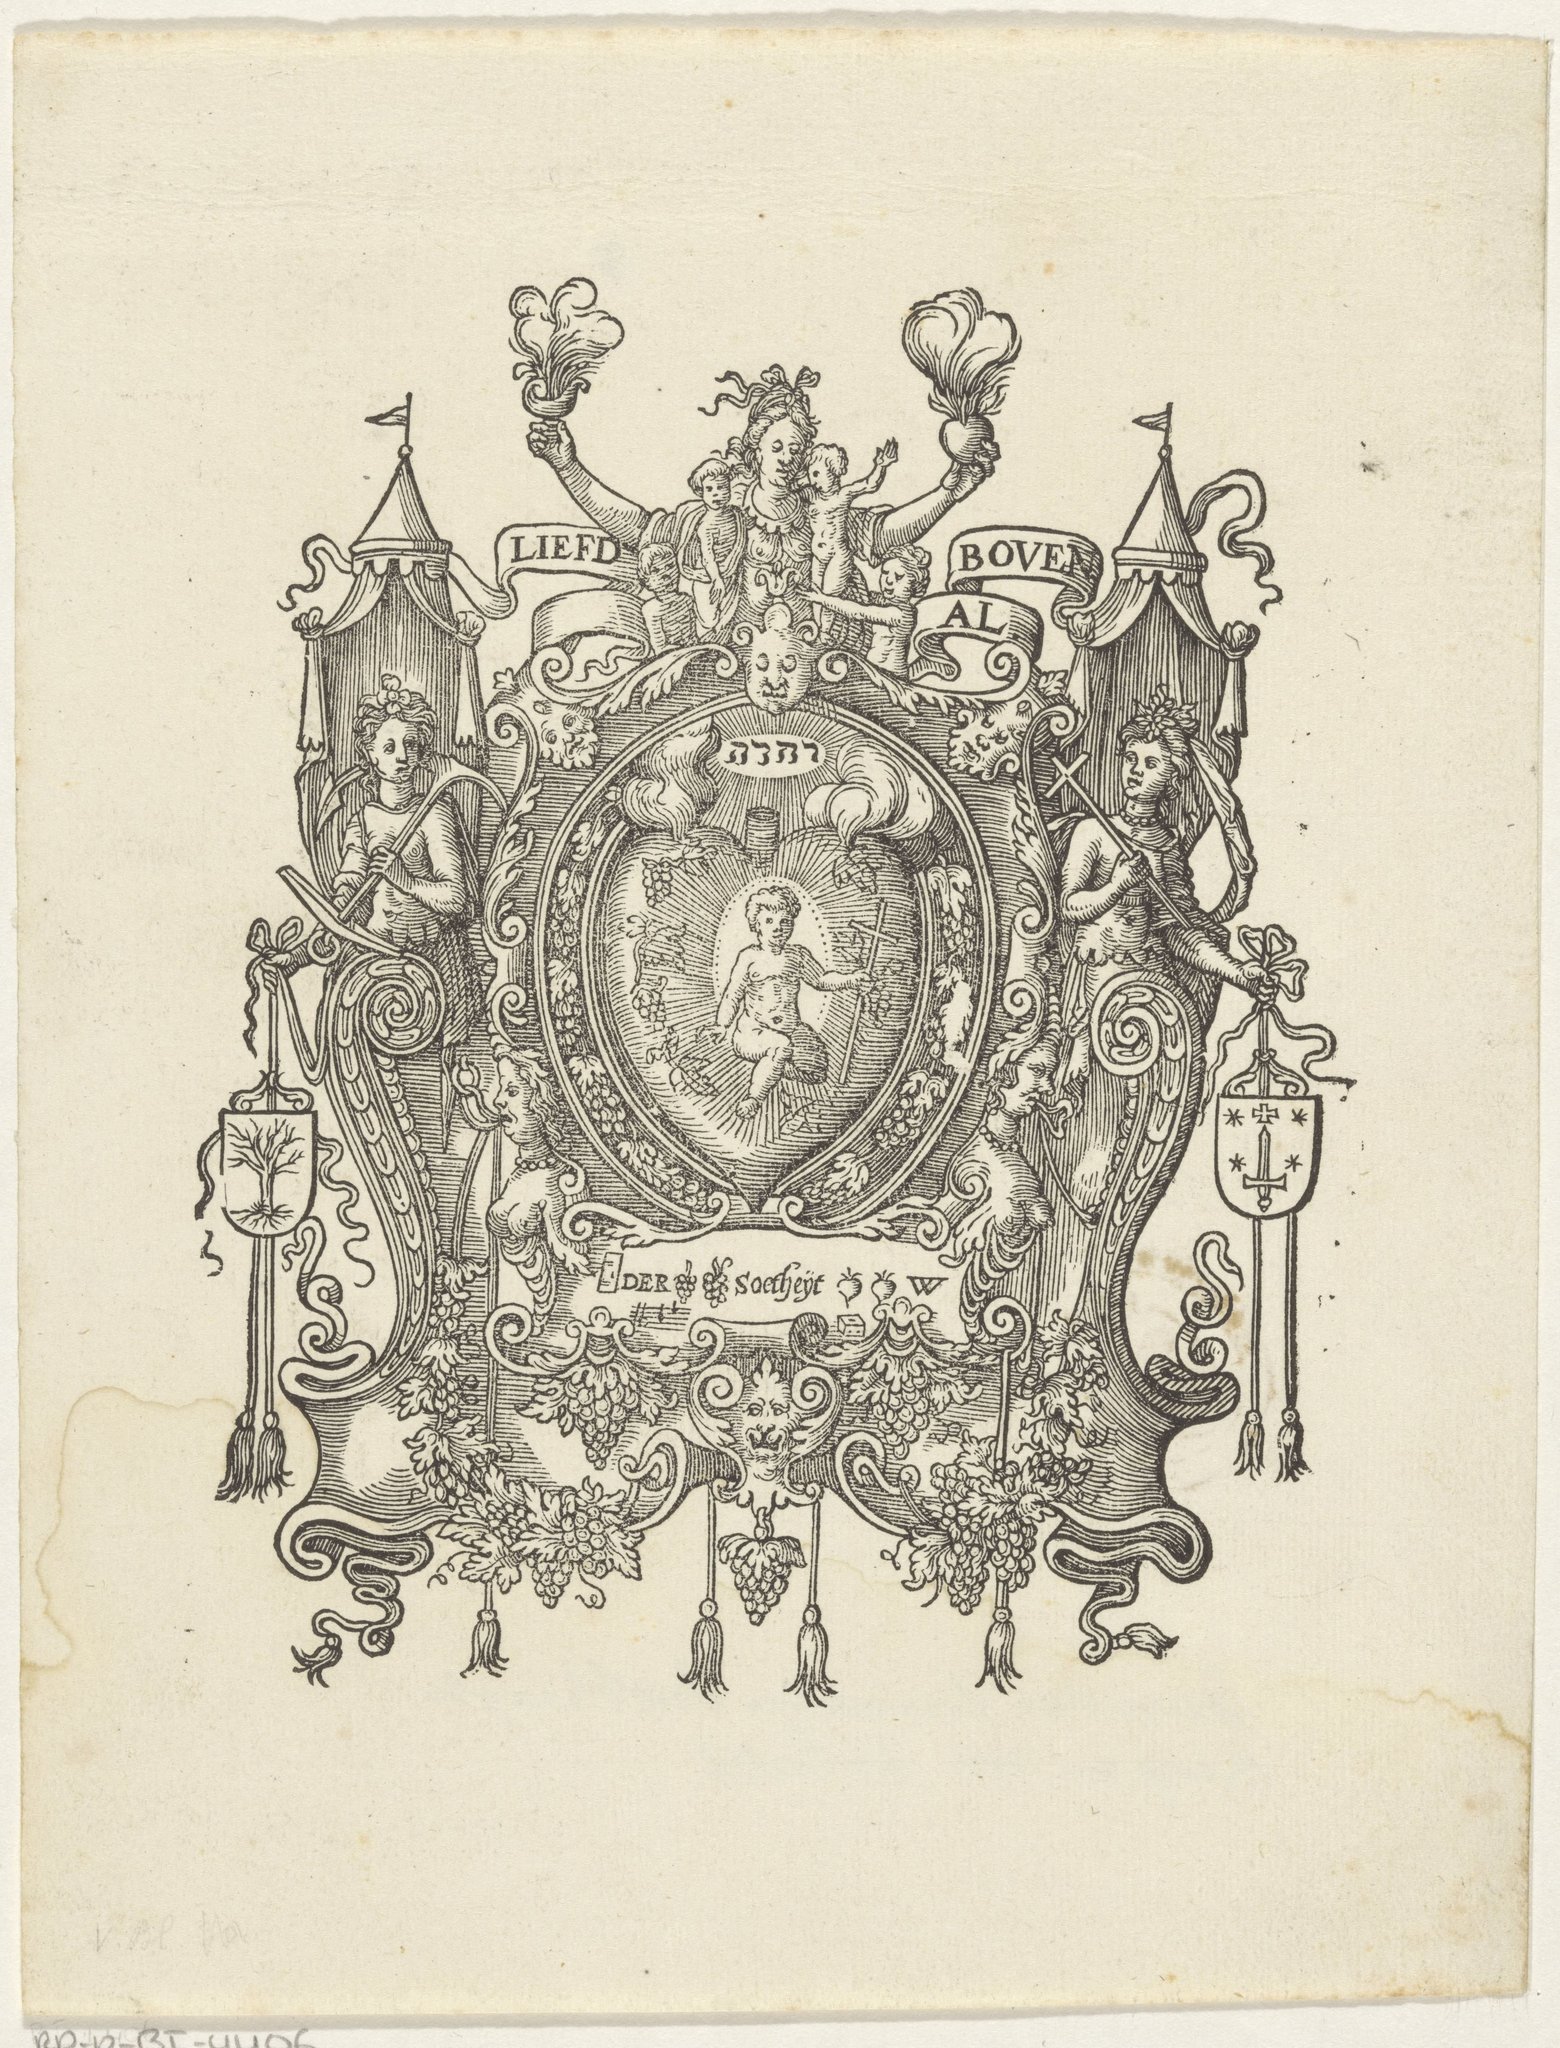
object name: print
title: Christuskind in een brandend hart met allegorische figuren en objecten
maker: Anonymous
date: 1600-1699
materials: paper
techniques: woodcut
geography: netherlands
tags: christ-child (with attributes), the sacred heart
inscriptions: collector's mark: Lugt 240